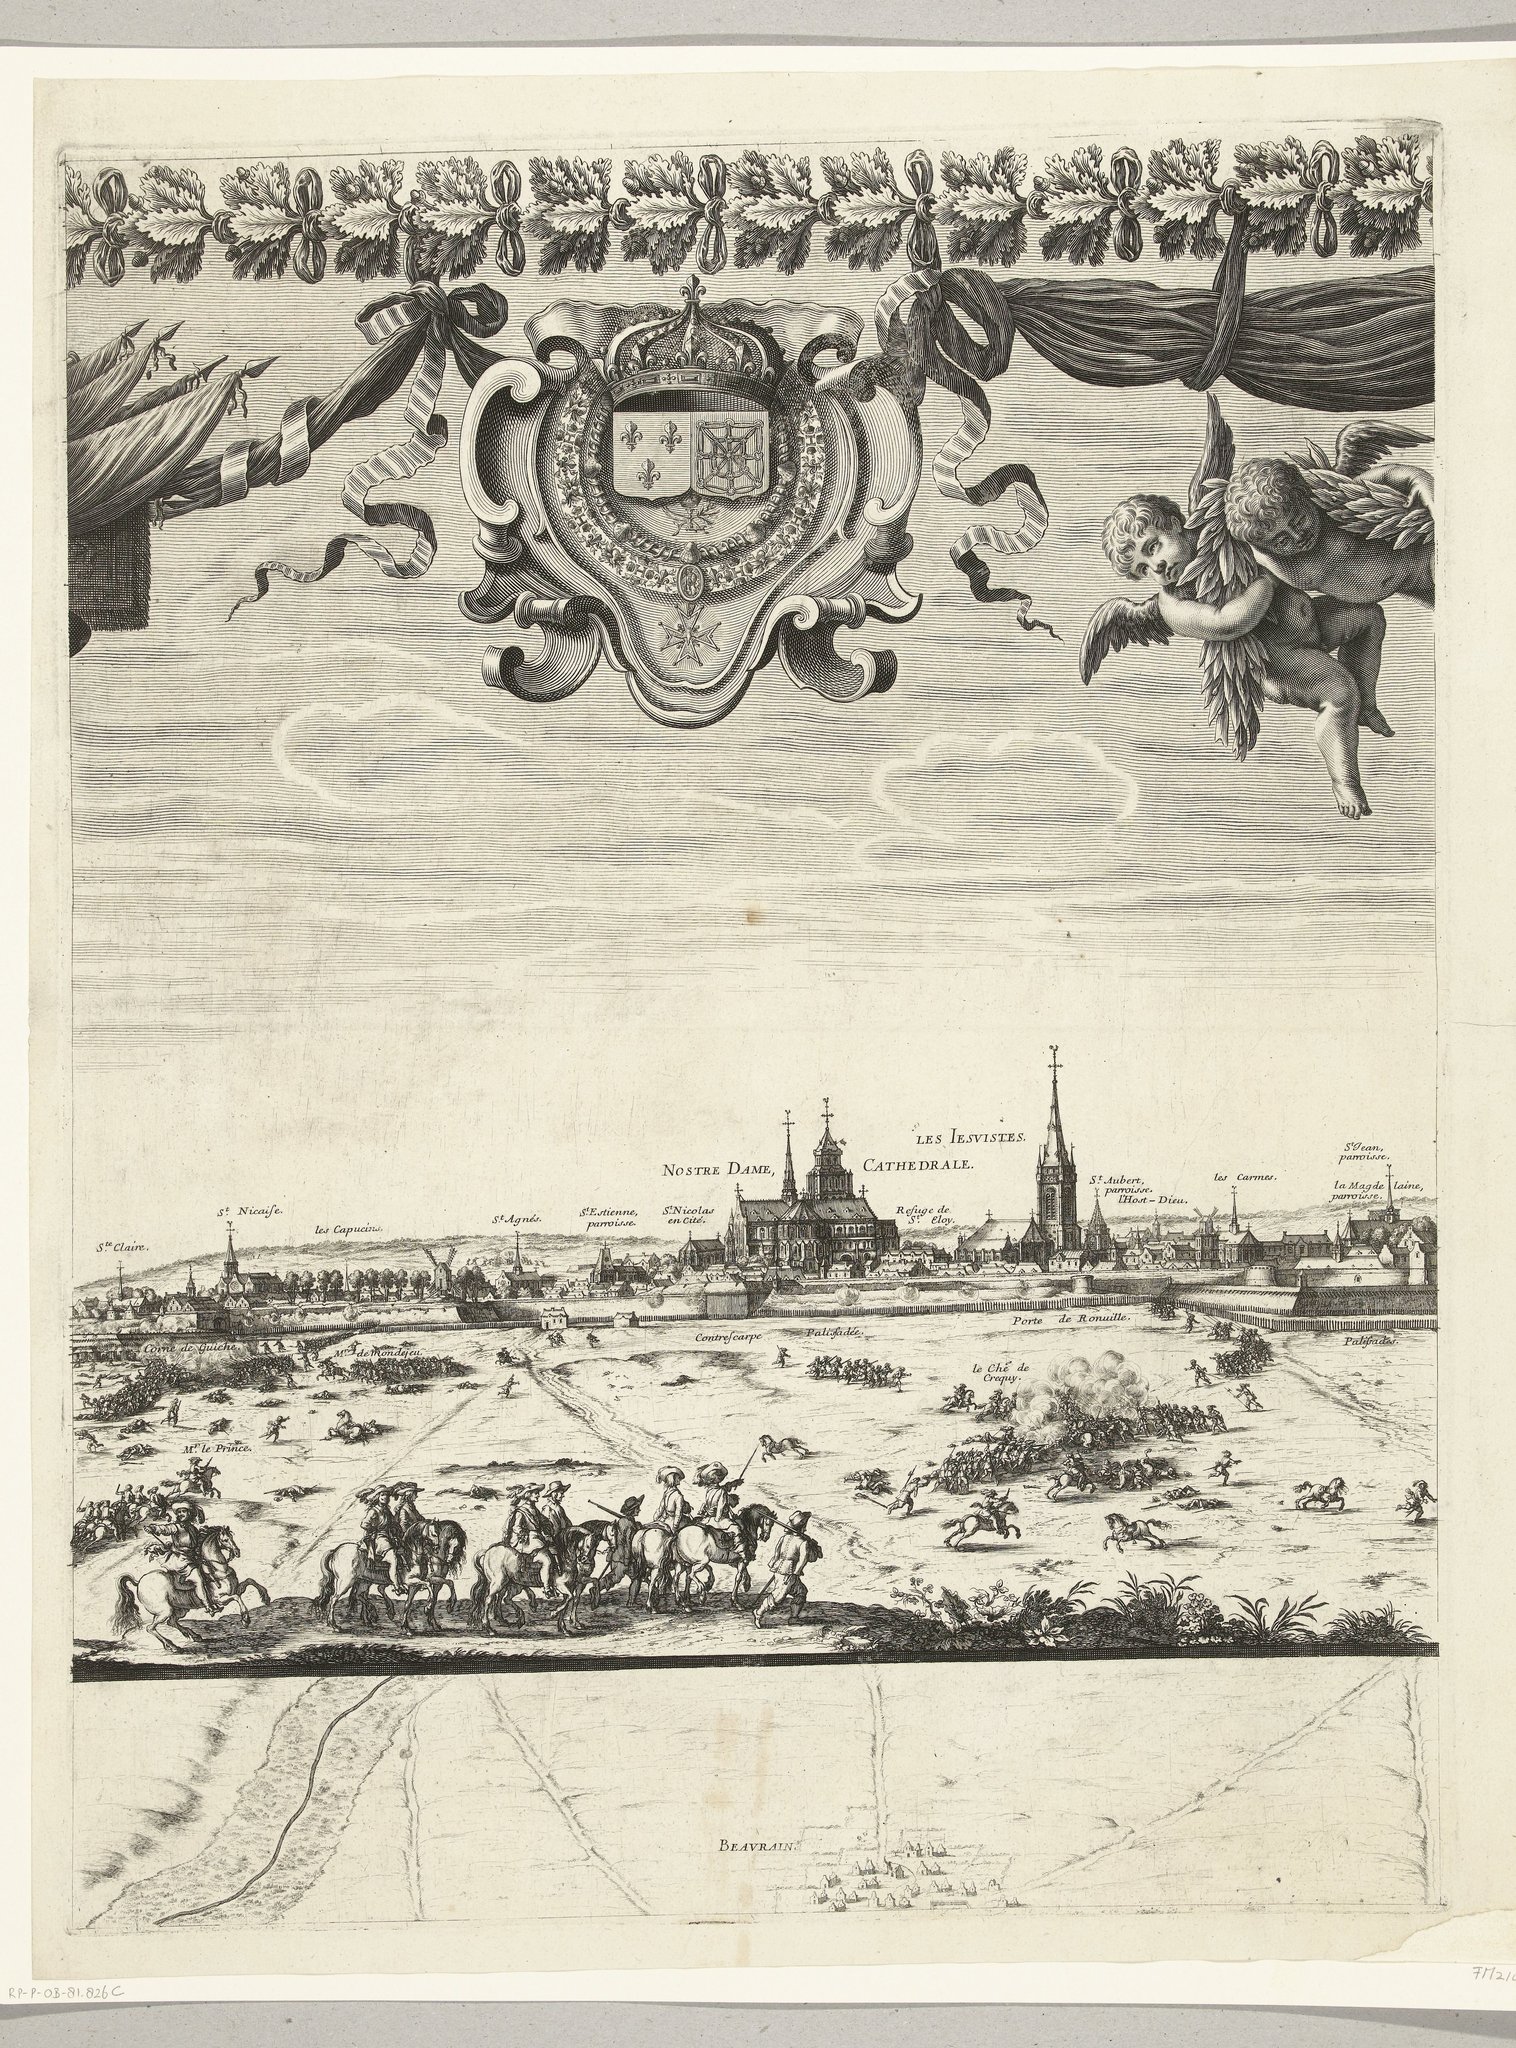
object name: propagandaprent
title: Ontzet van Arras, belegerd door de Spanjaarden (bovenste rij, plaat 2), 1654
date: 1655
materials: paper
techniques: engraving, etching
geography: france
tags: vienna, leopold willem van oostenrijk (landvoogd der zuidelijke nederlanden), raising the siege with outside assistance, relief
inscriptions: date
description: Ontzet van de stad Arras (Atrecht), belegerd door de Spanjaarden, 23-25 augustus 1654. Arras ontzet door het Franse leger onder de maarschalk Turenne van het beleg door de Spanjaarden onder Louis de Condé en aartshertog Leopold Willem. Tweede blad in de bovenste rij. Boven een wapen en putti, onder een deel van het profiel van de stad en de kaart van het beleg. Onderdeel van een ongemonteerd geheel bestaande uit een titelblad en een grote voorstelling op vijftien platen (de halve plaat rechtsonder ontbreekt).